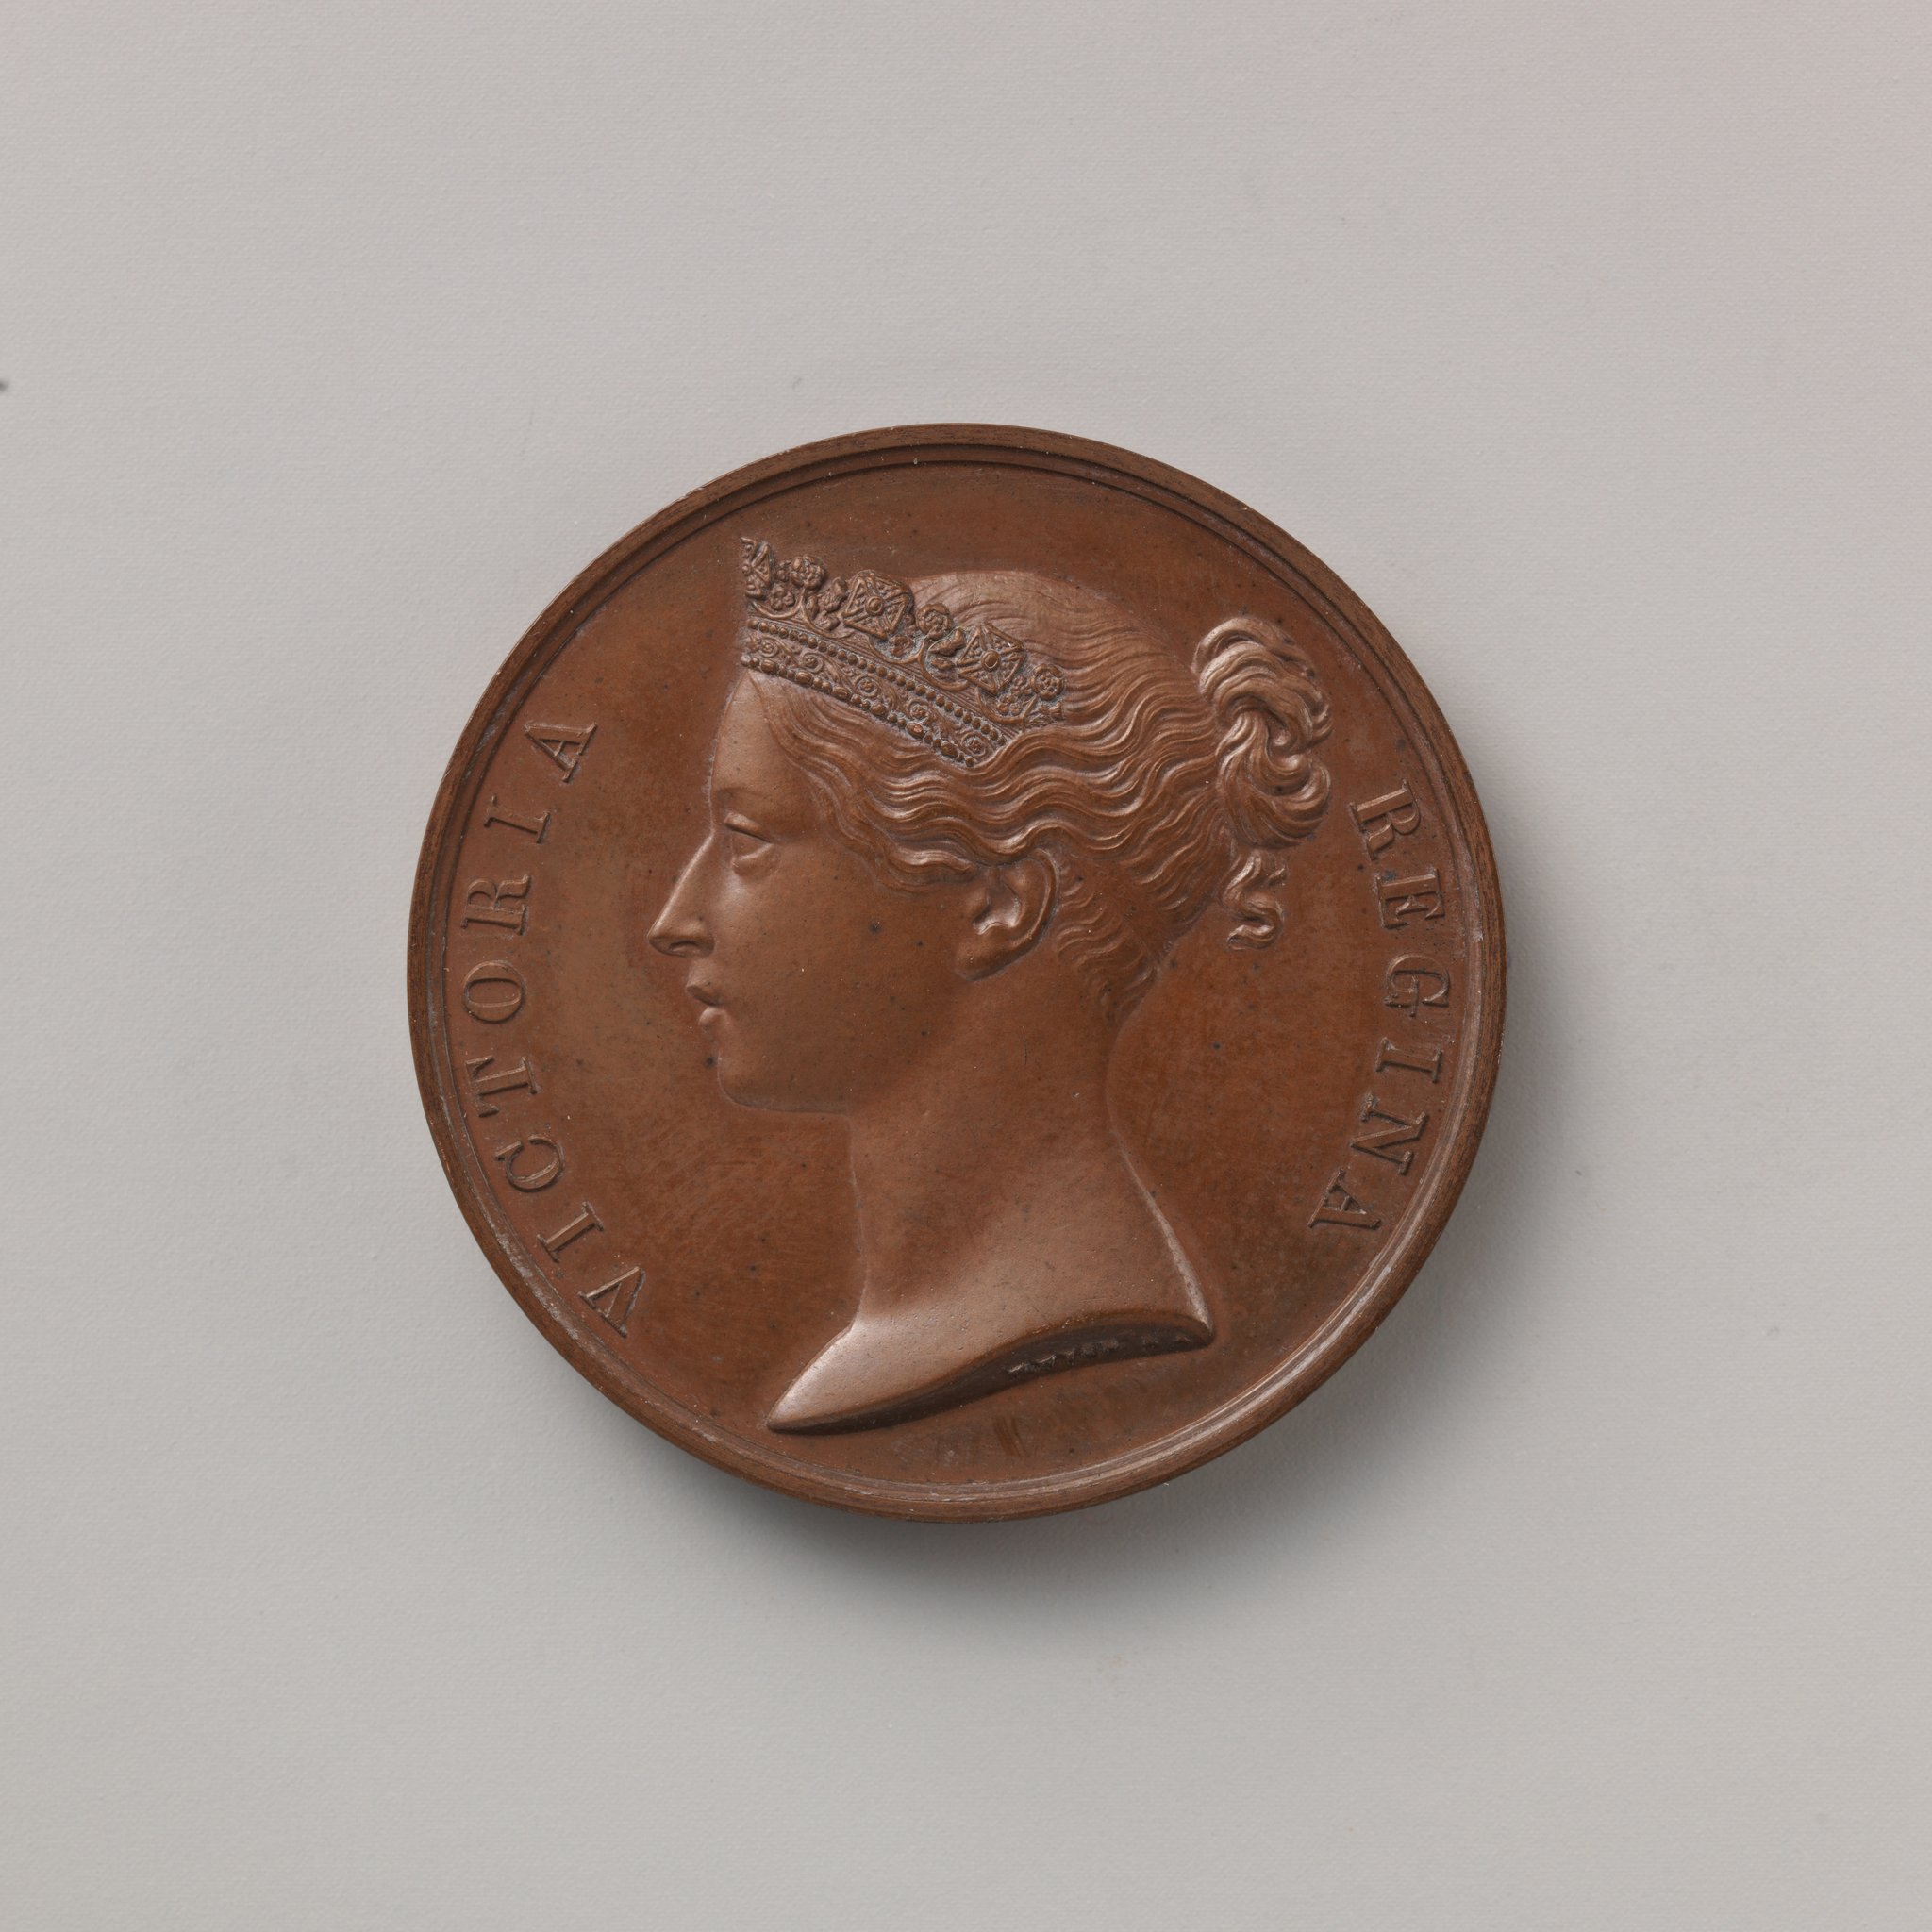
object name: medal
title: The South African Medal, Issued for the Campaigns of 1877–79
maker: william wyon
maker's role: artist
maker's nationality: british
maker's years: 1795-1851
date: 1879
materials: bronze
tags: profiles,women,lions